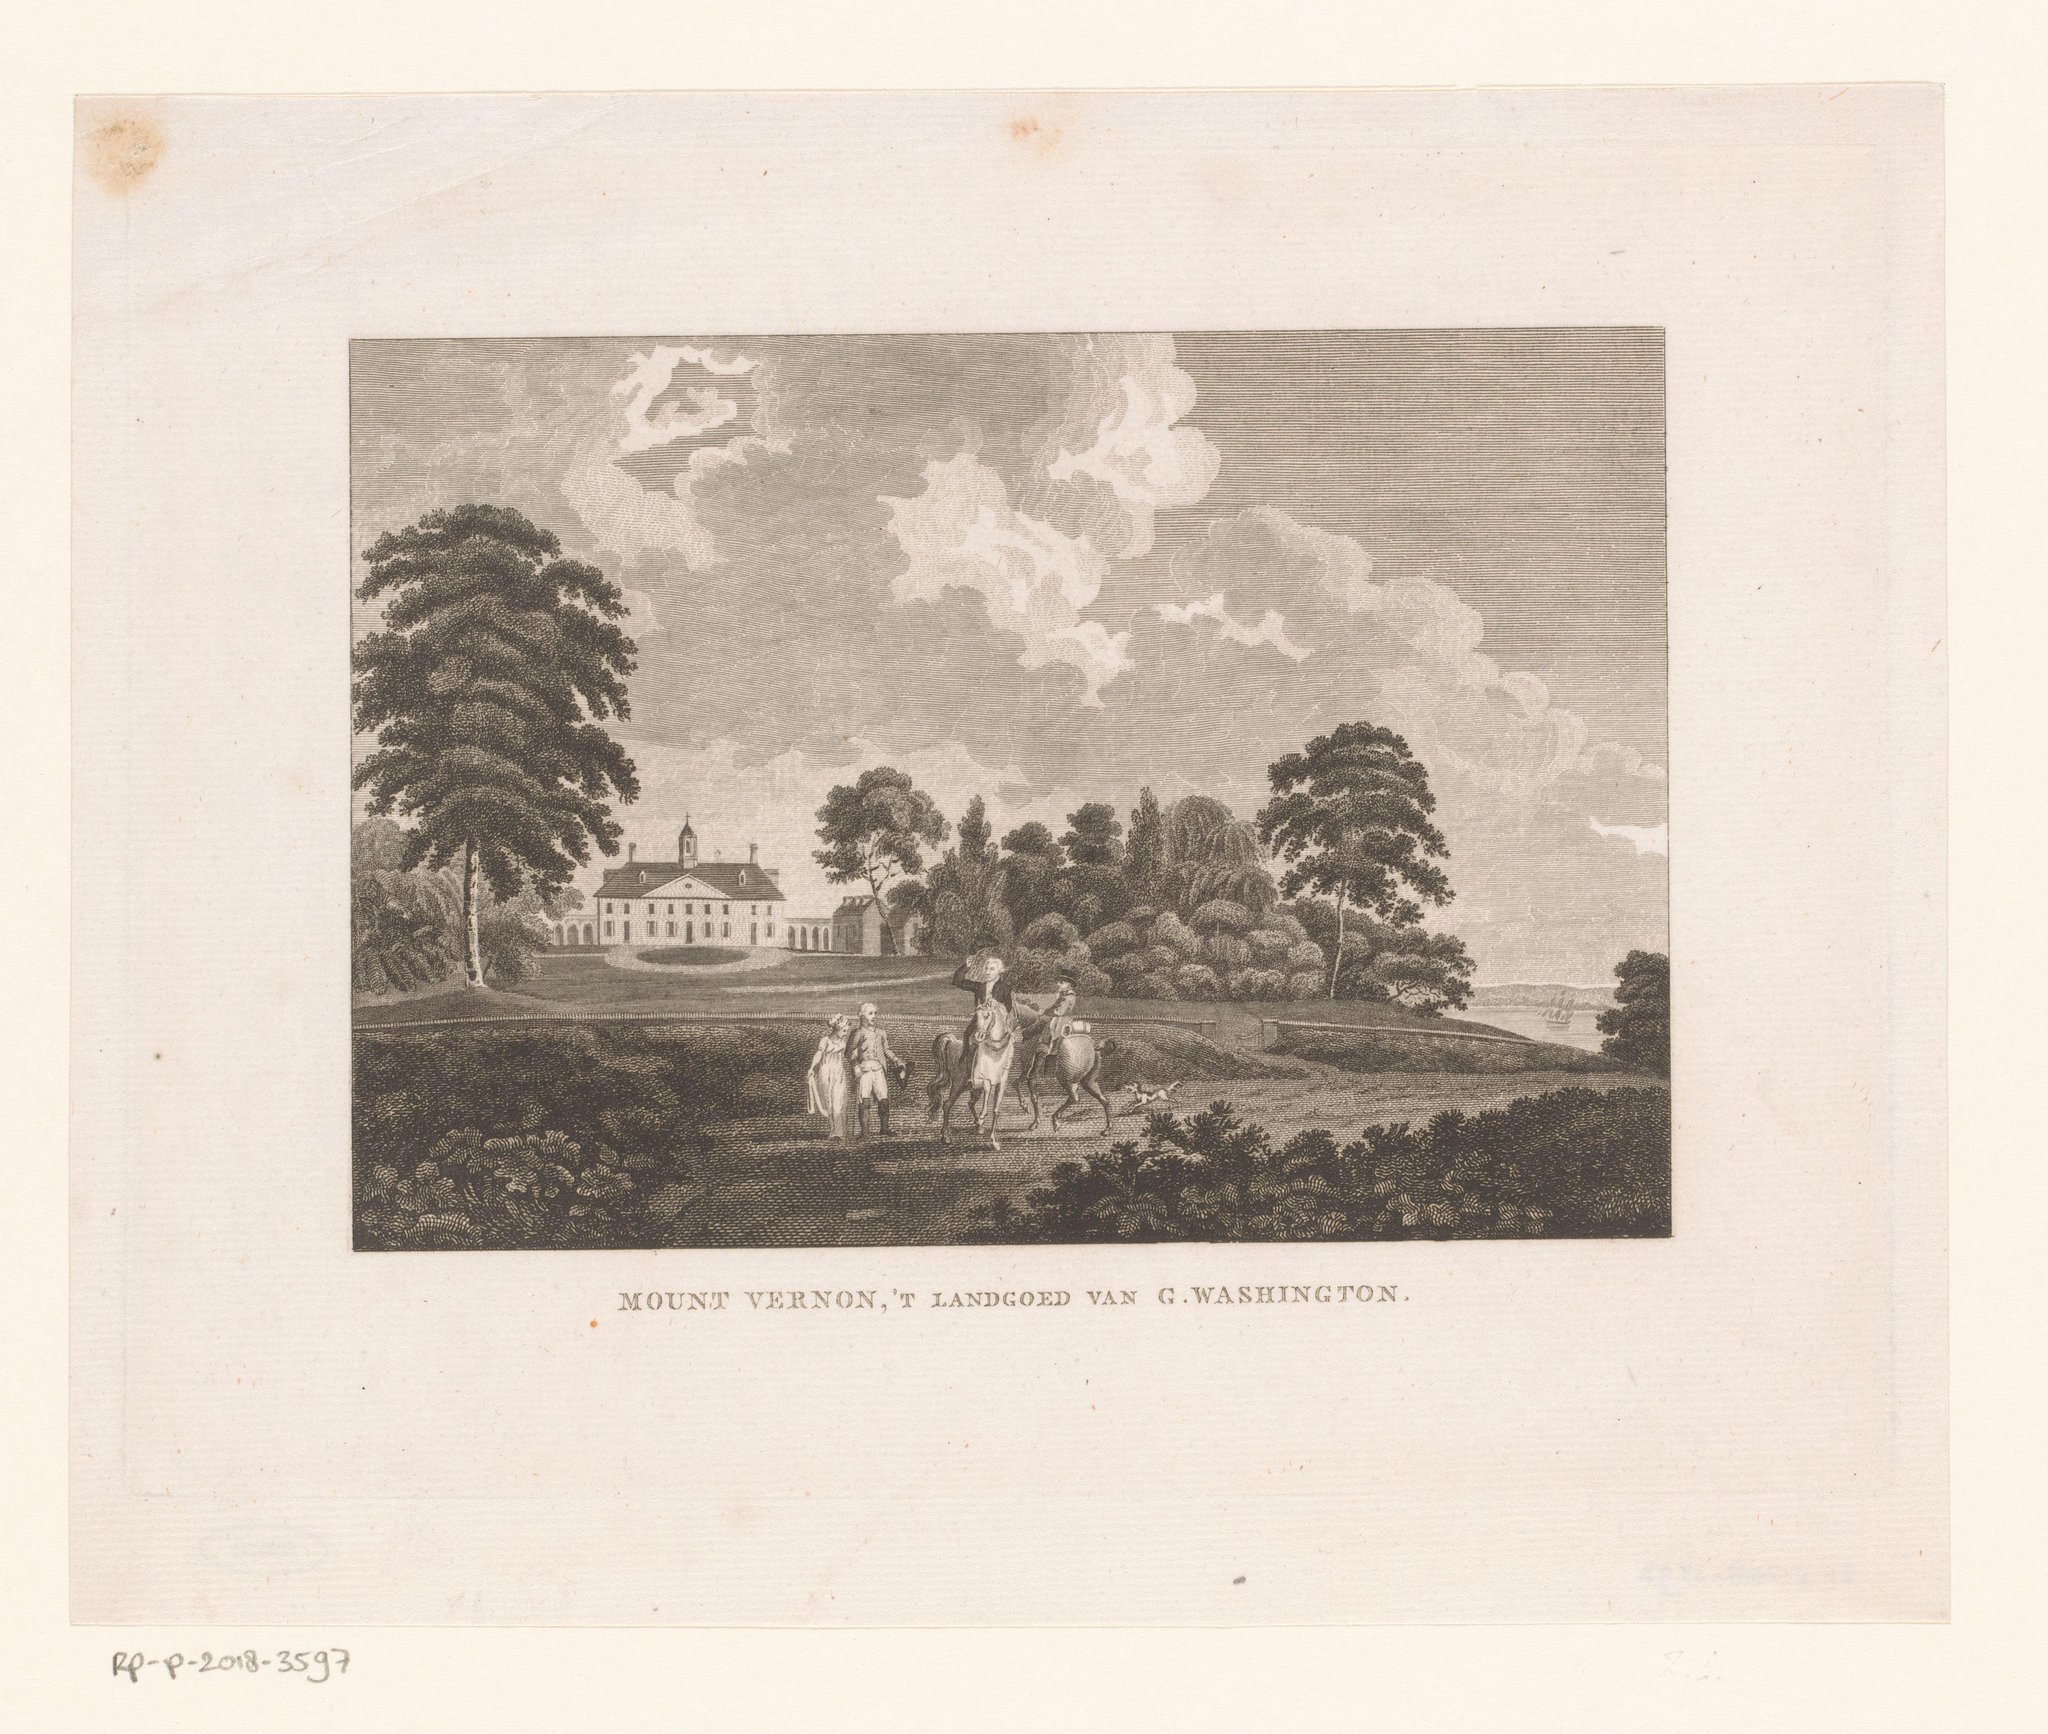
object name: print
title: Mount Vernon, 't landgoed van G. Washington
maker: Anonymous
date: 1820-1880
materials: paper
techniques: engraving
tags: country-house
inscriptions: collector's mark: Lugt 2228